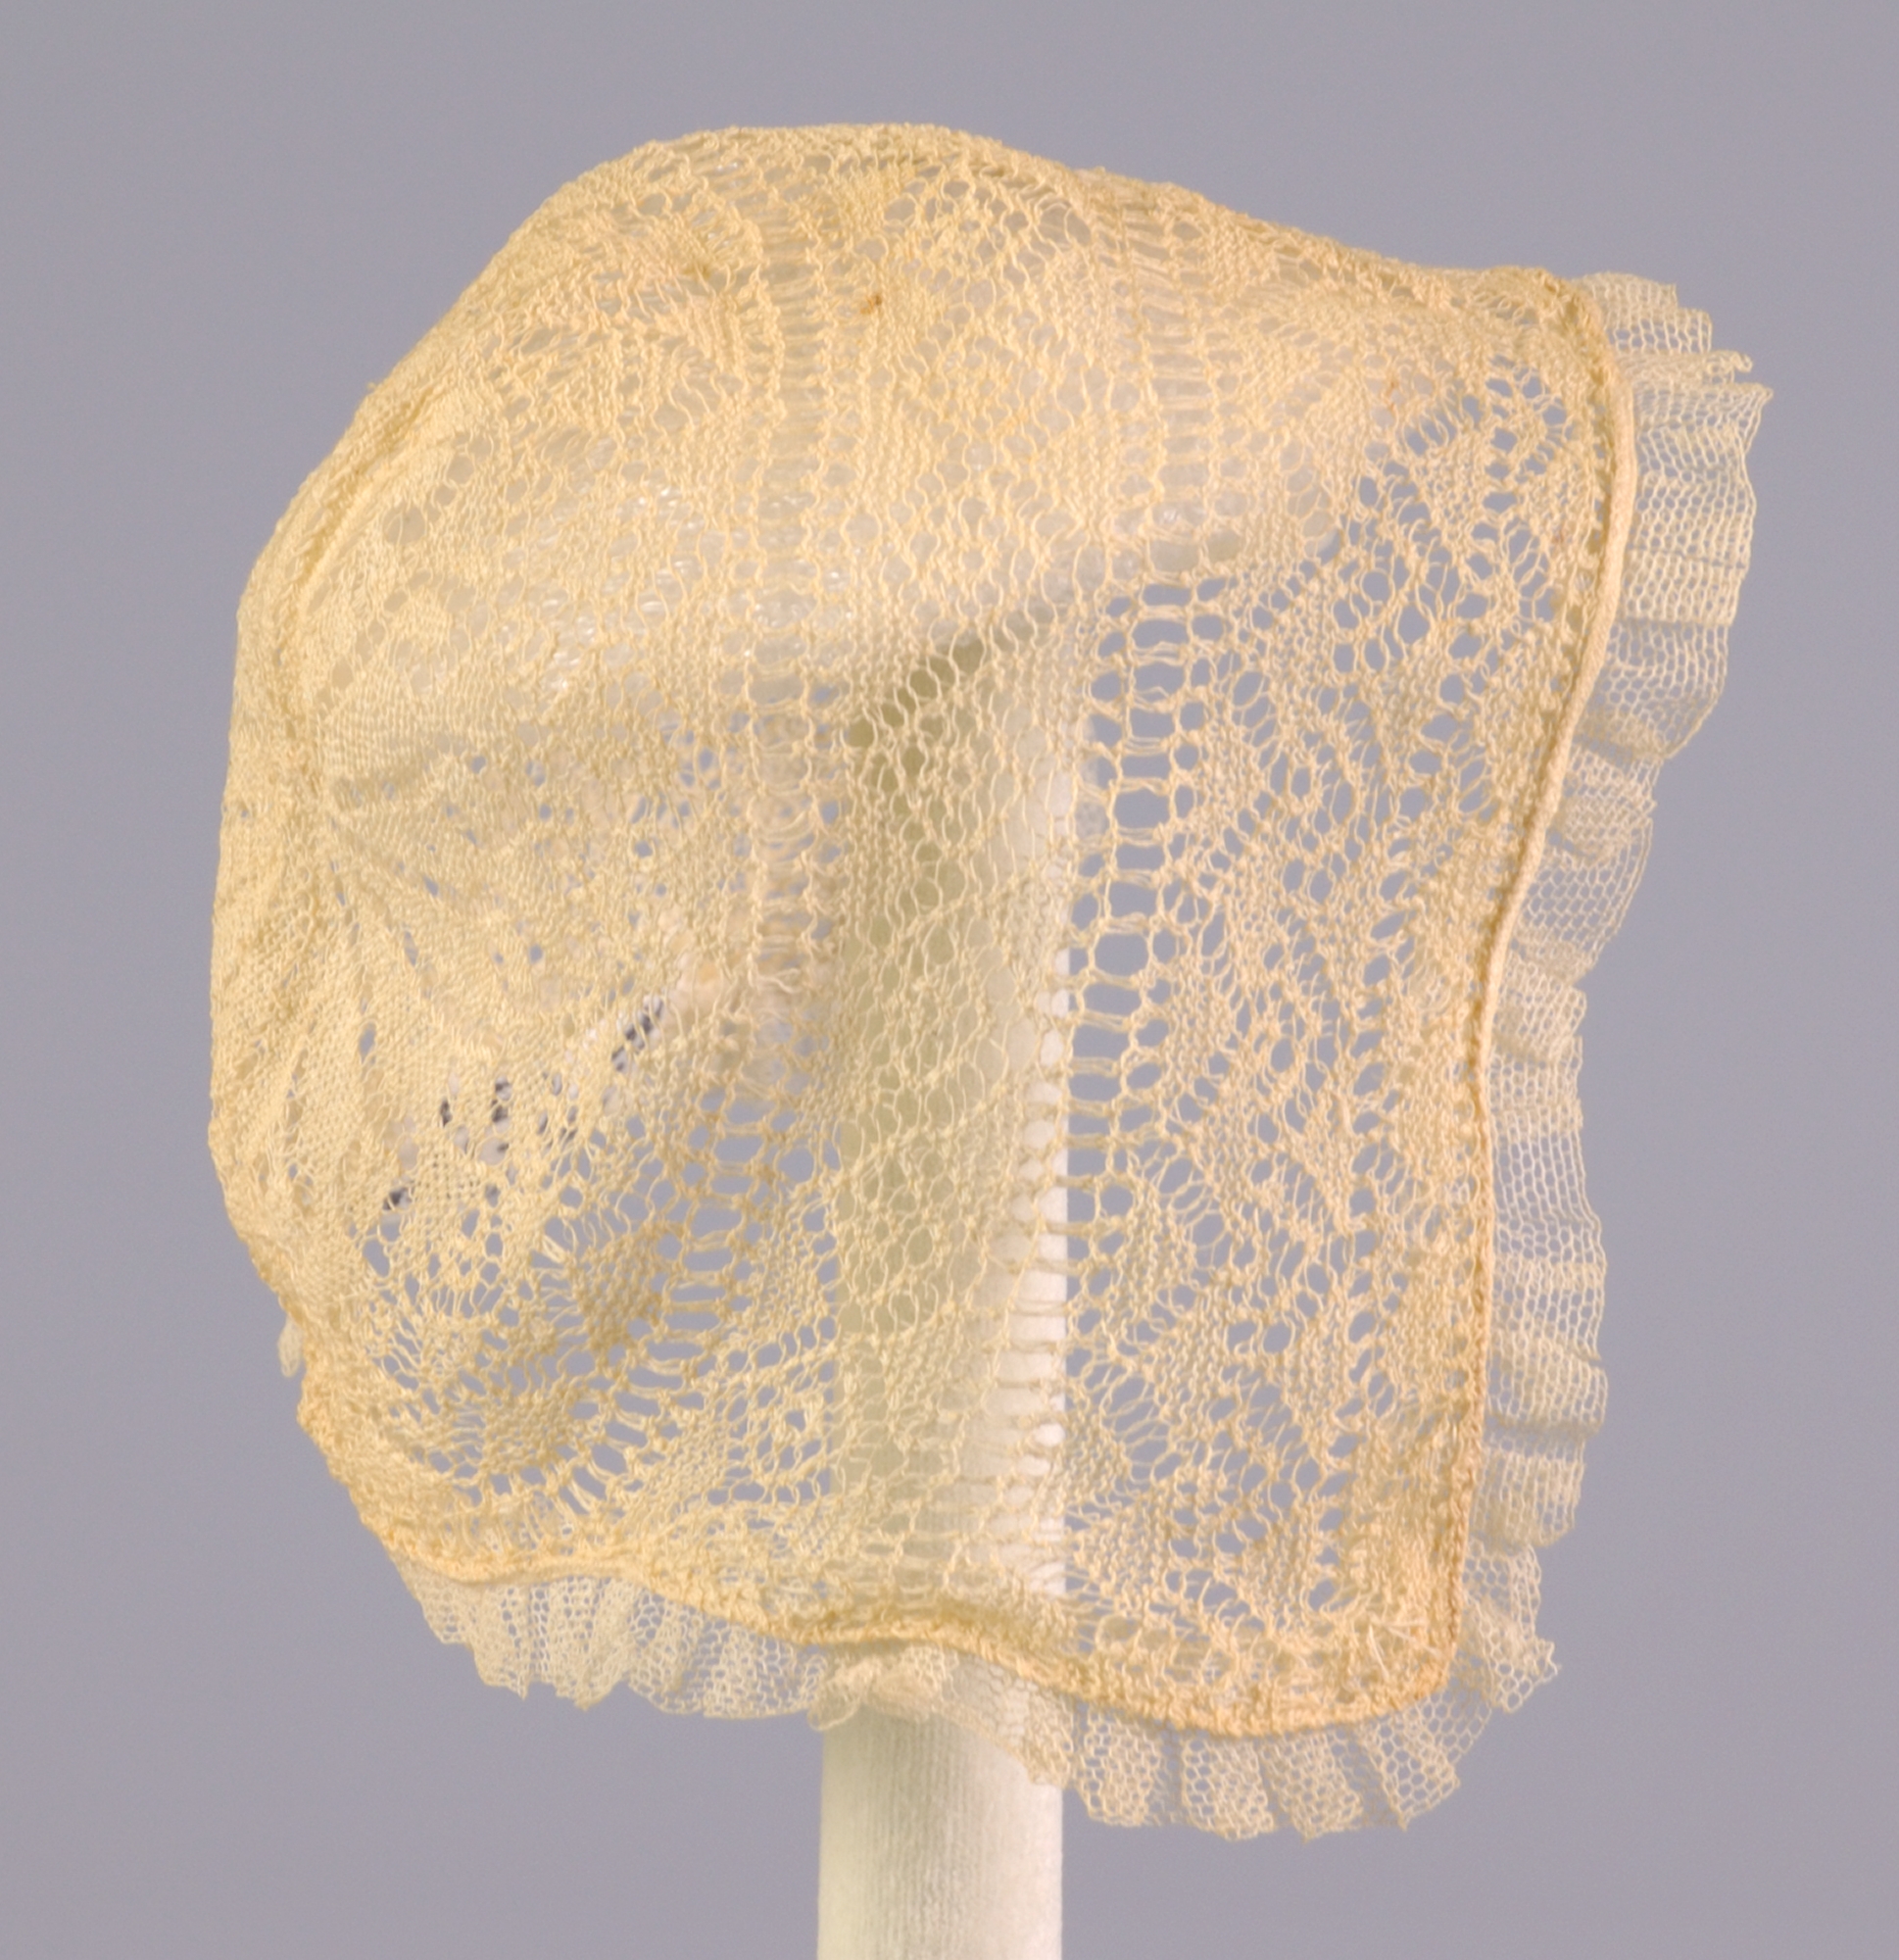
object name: cap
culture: american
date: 1830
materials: cotton